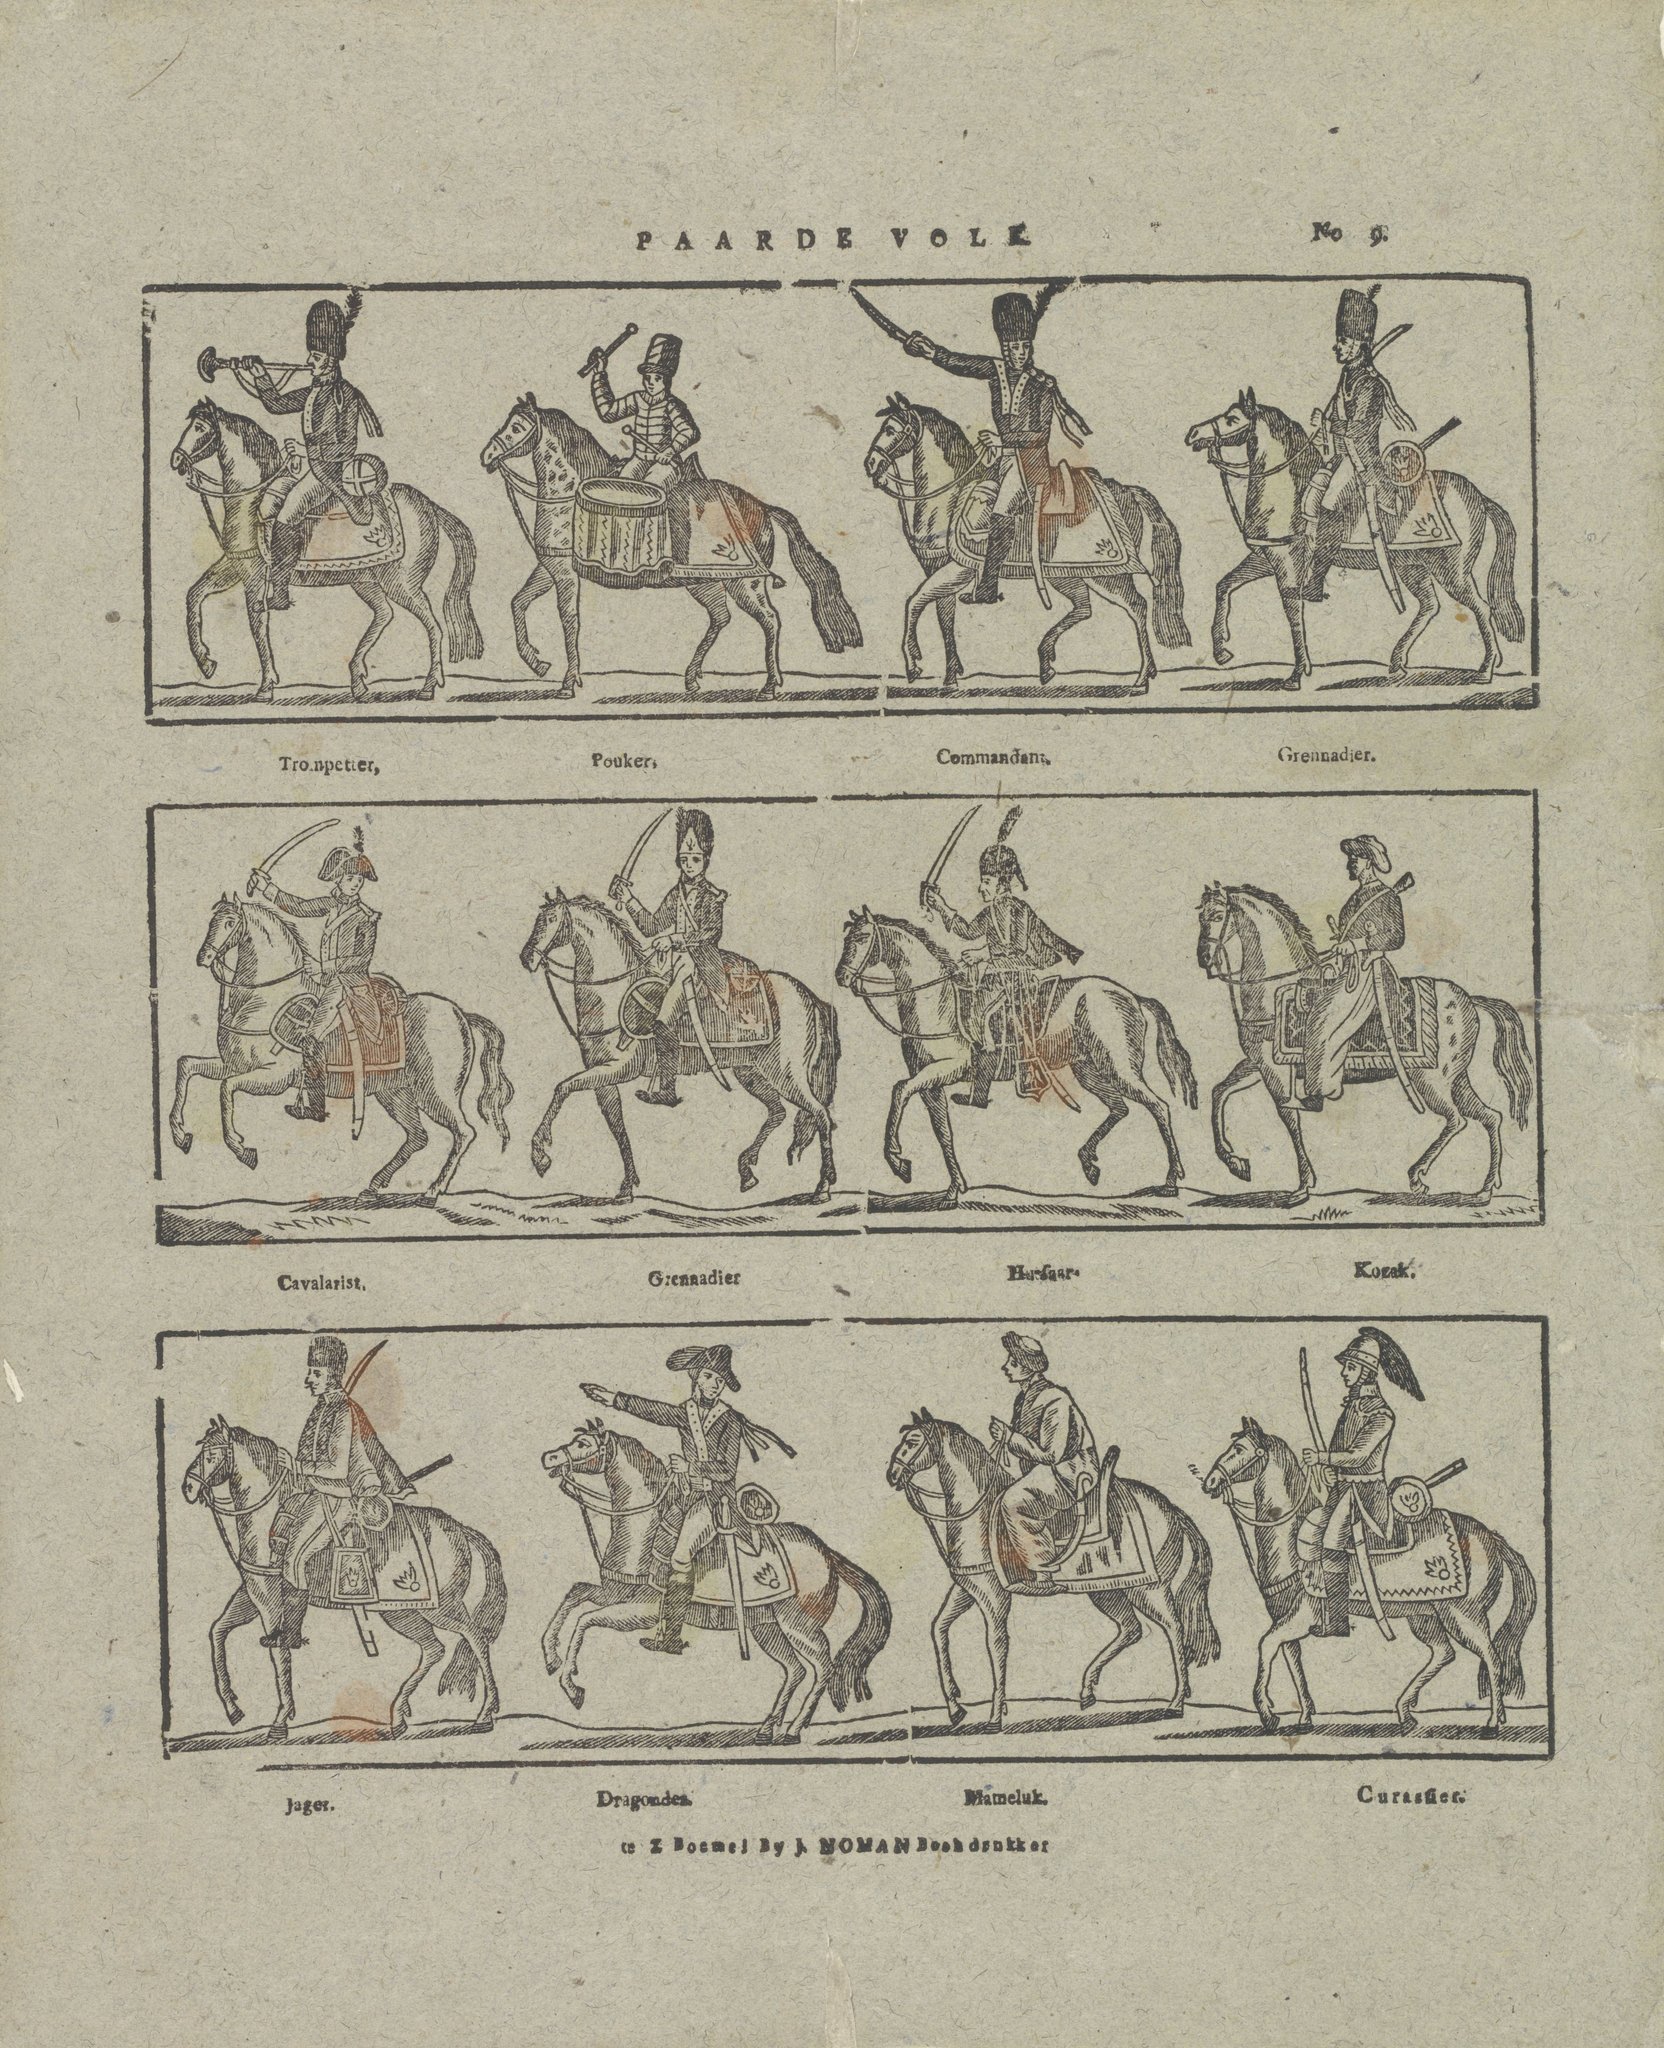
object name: popular print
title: Paarde volk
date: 1806-1830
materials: paper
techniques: colour, letterpress printing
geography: zaltbommel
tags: warfare; military affairs (+ cavalry, horsemen), the soldier; the soldier's life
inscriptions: collector's mark: Lugt 2760, inscription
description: Blad met 3 voorstellingen van telkens vier militairen te paard. Onder elke afbeelding een onderschrift. Genummerd rechtsboven: No. 9.